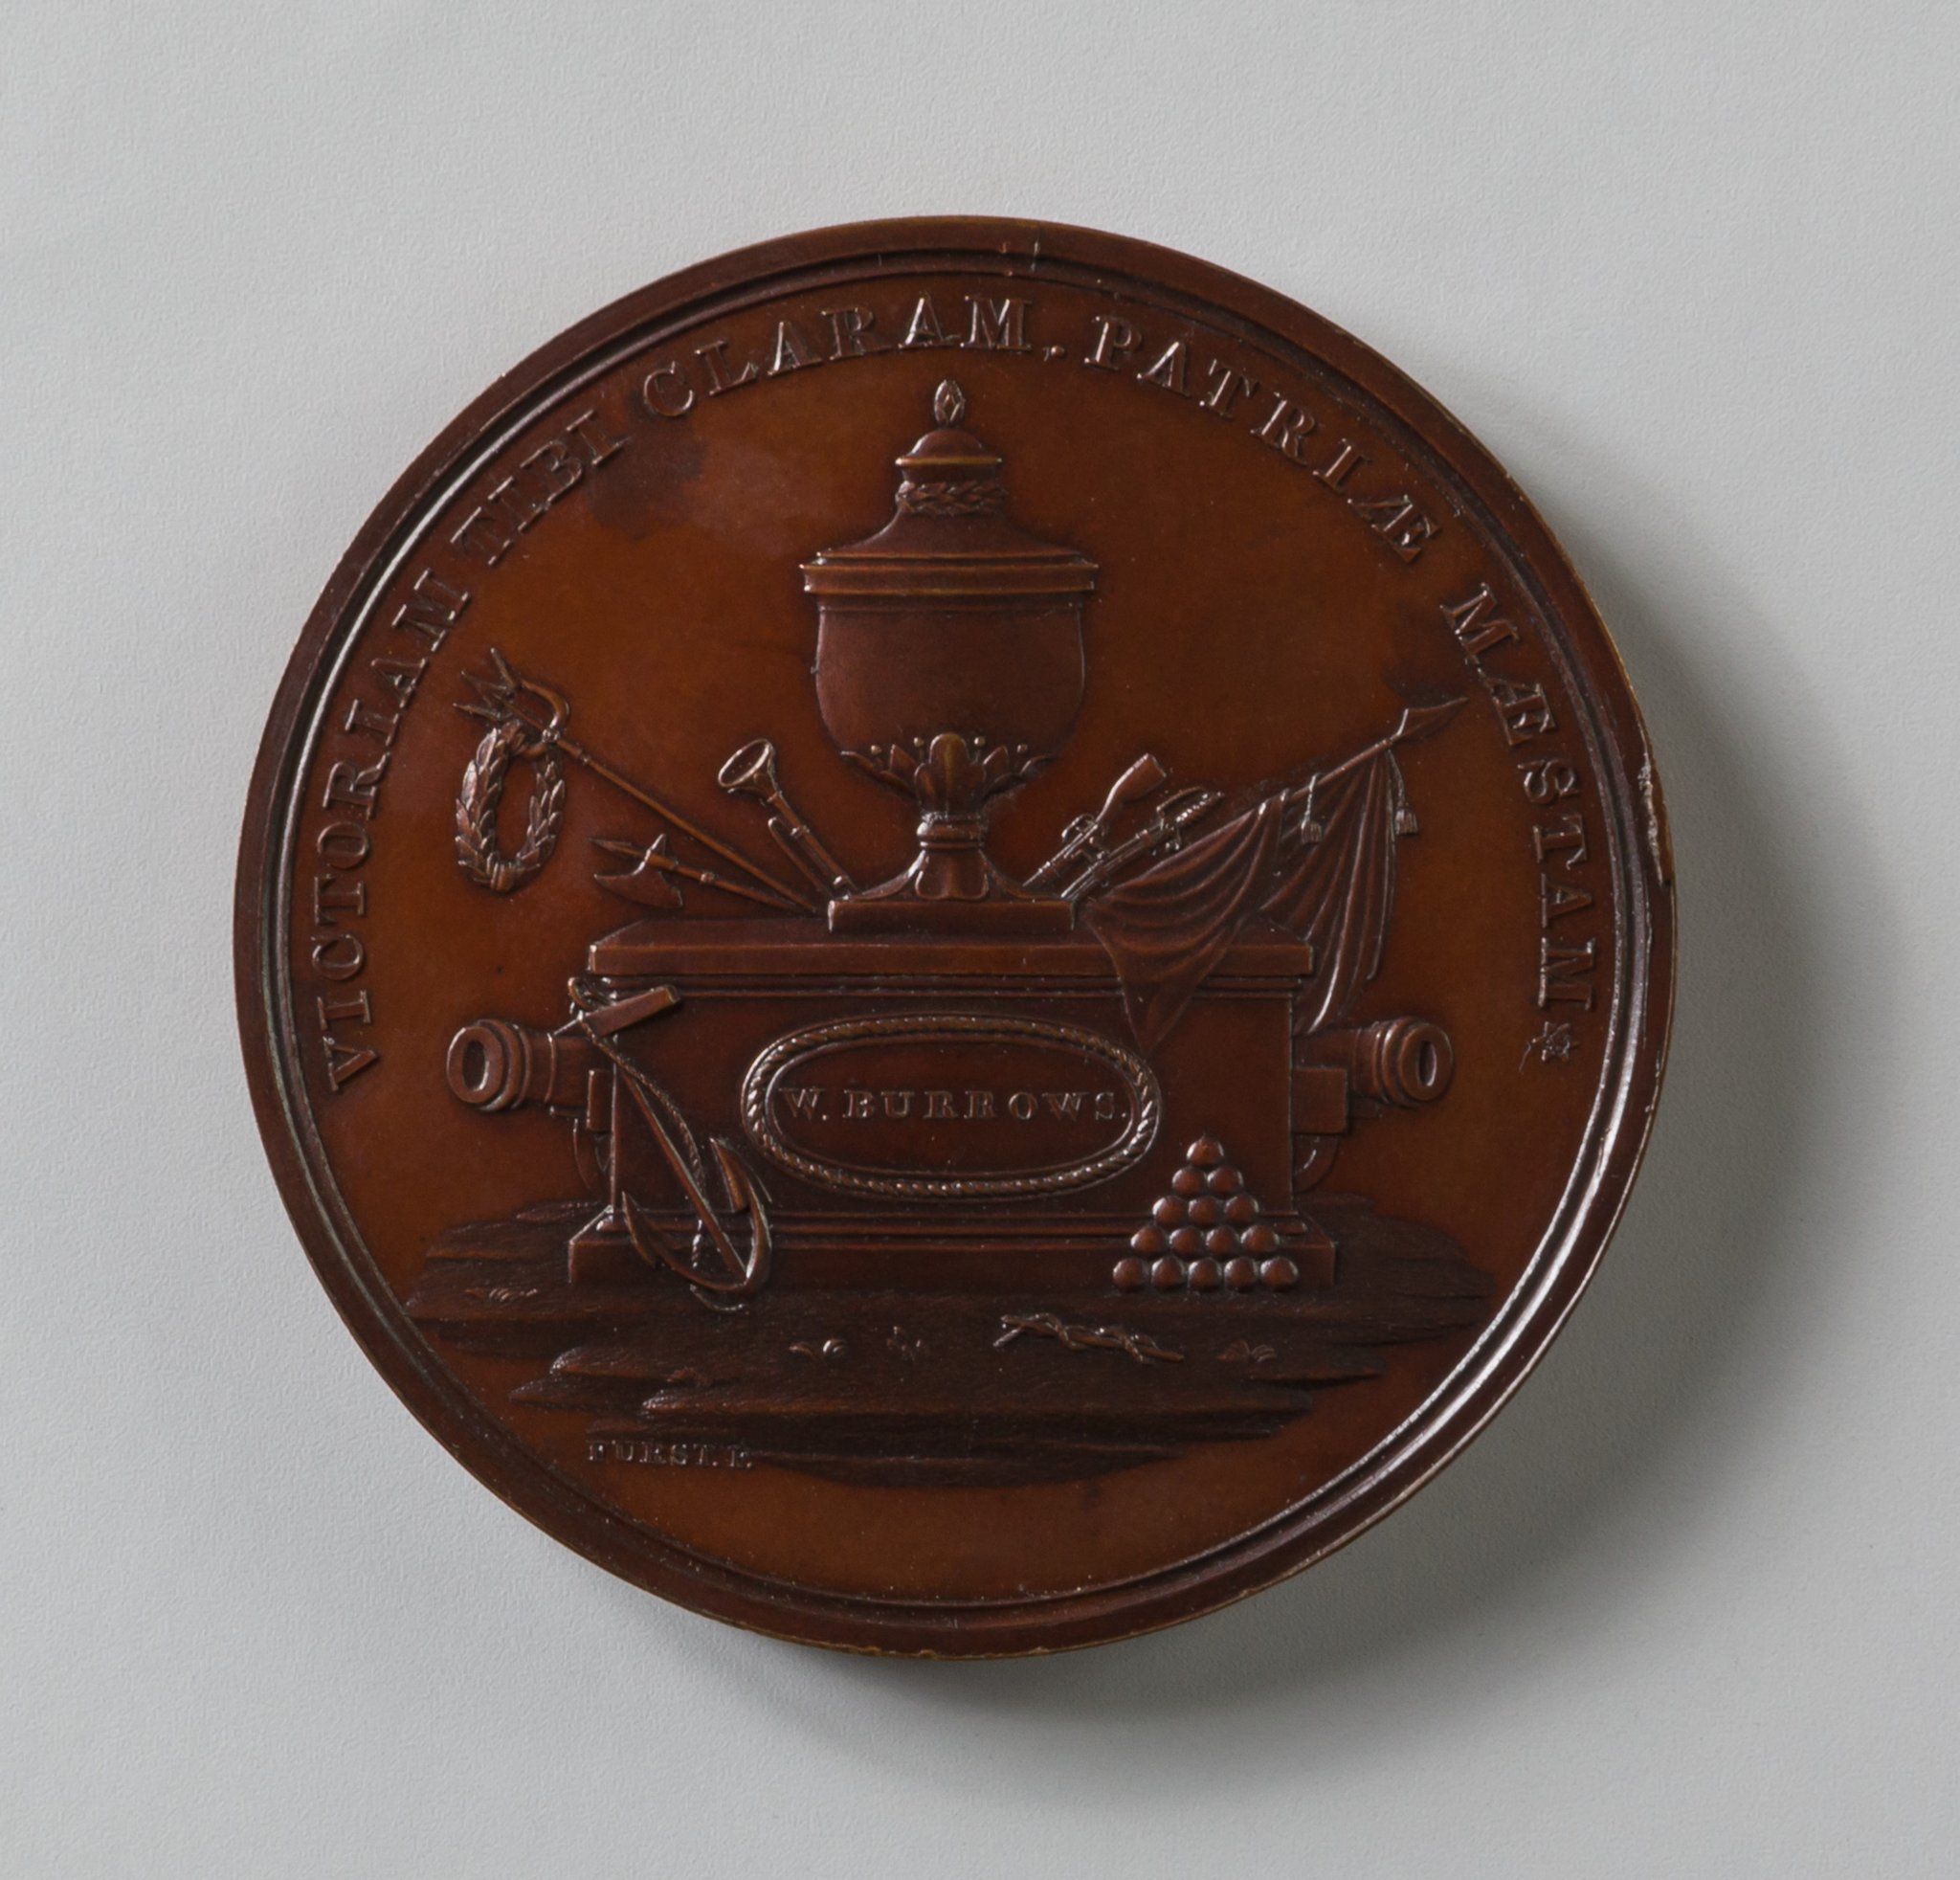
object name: medal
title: Medal in Memory of Lieutenant William Burrows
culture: american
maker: moritz fürst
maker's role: maker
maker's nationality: hungarian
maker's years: 1782-1882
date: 1800-1830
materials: bronze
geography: united states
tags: cannons